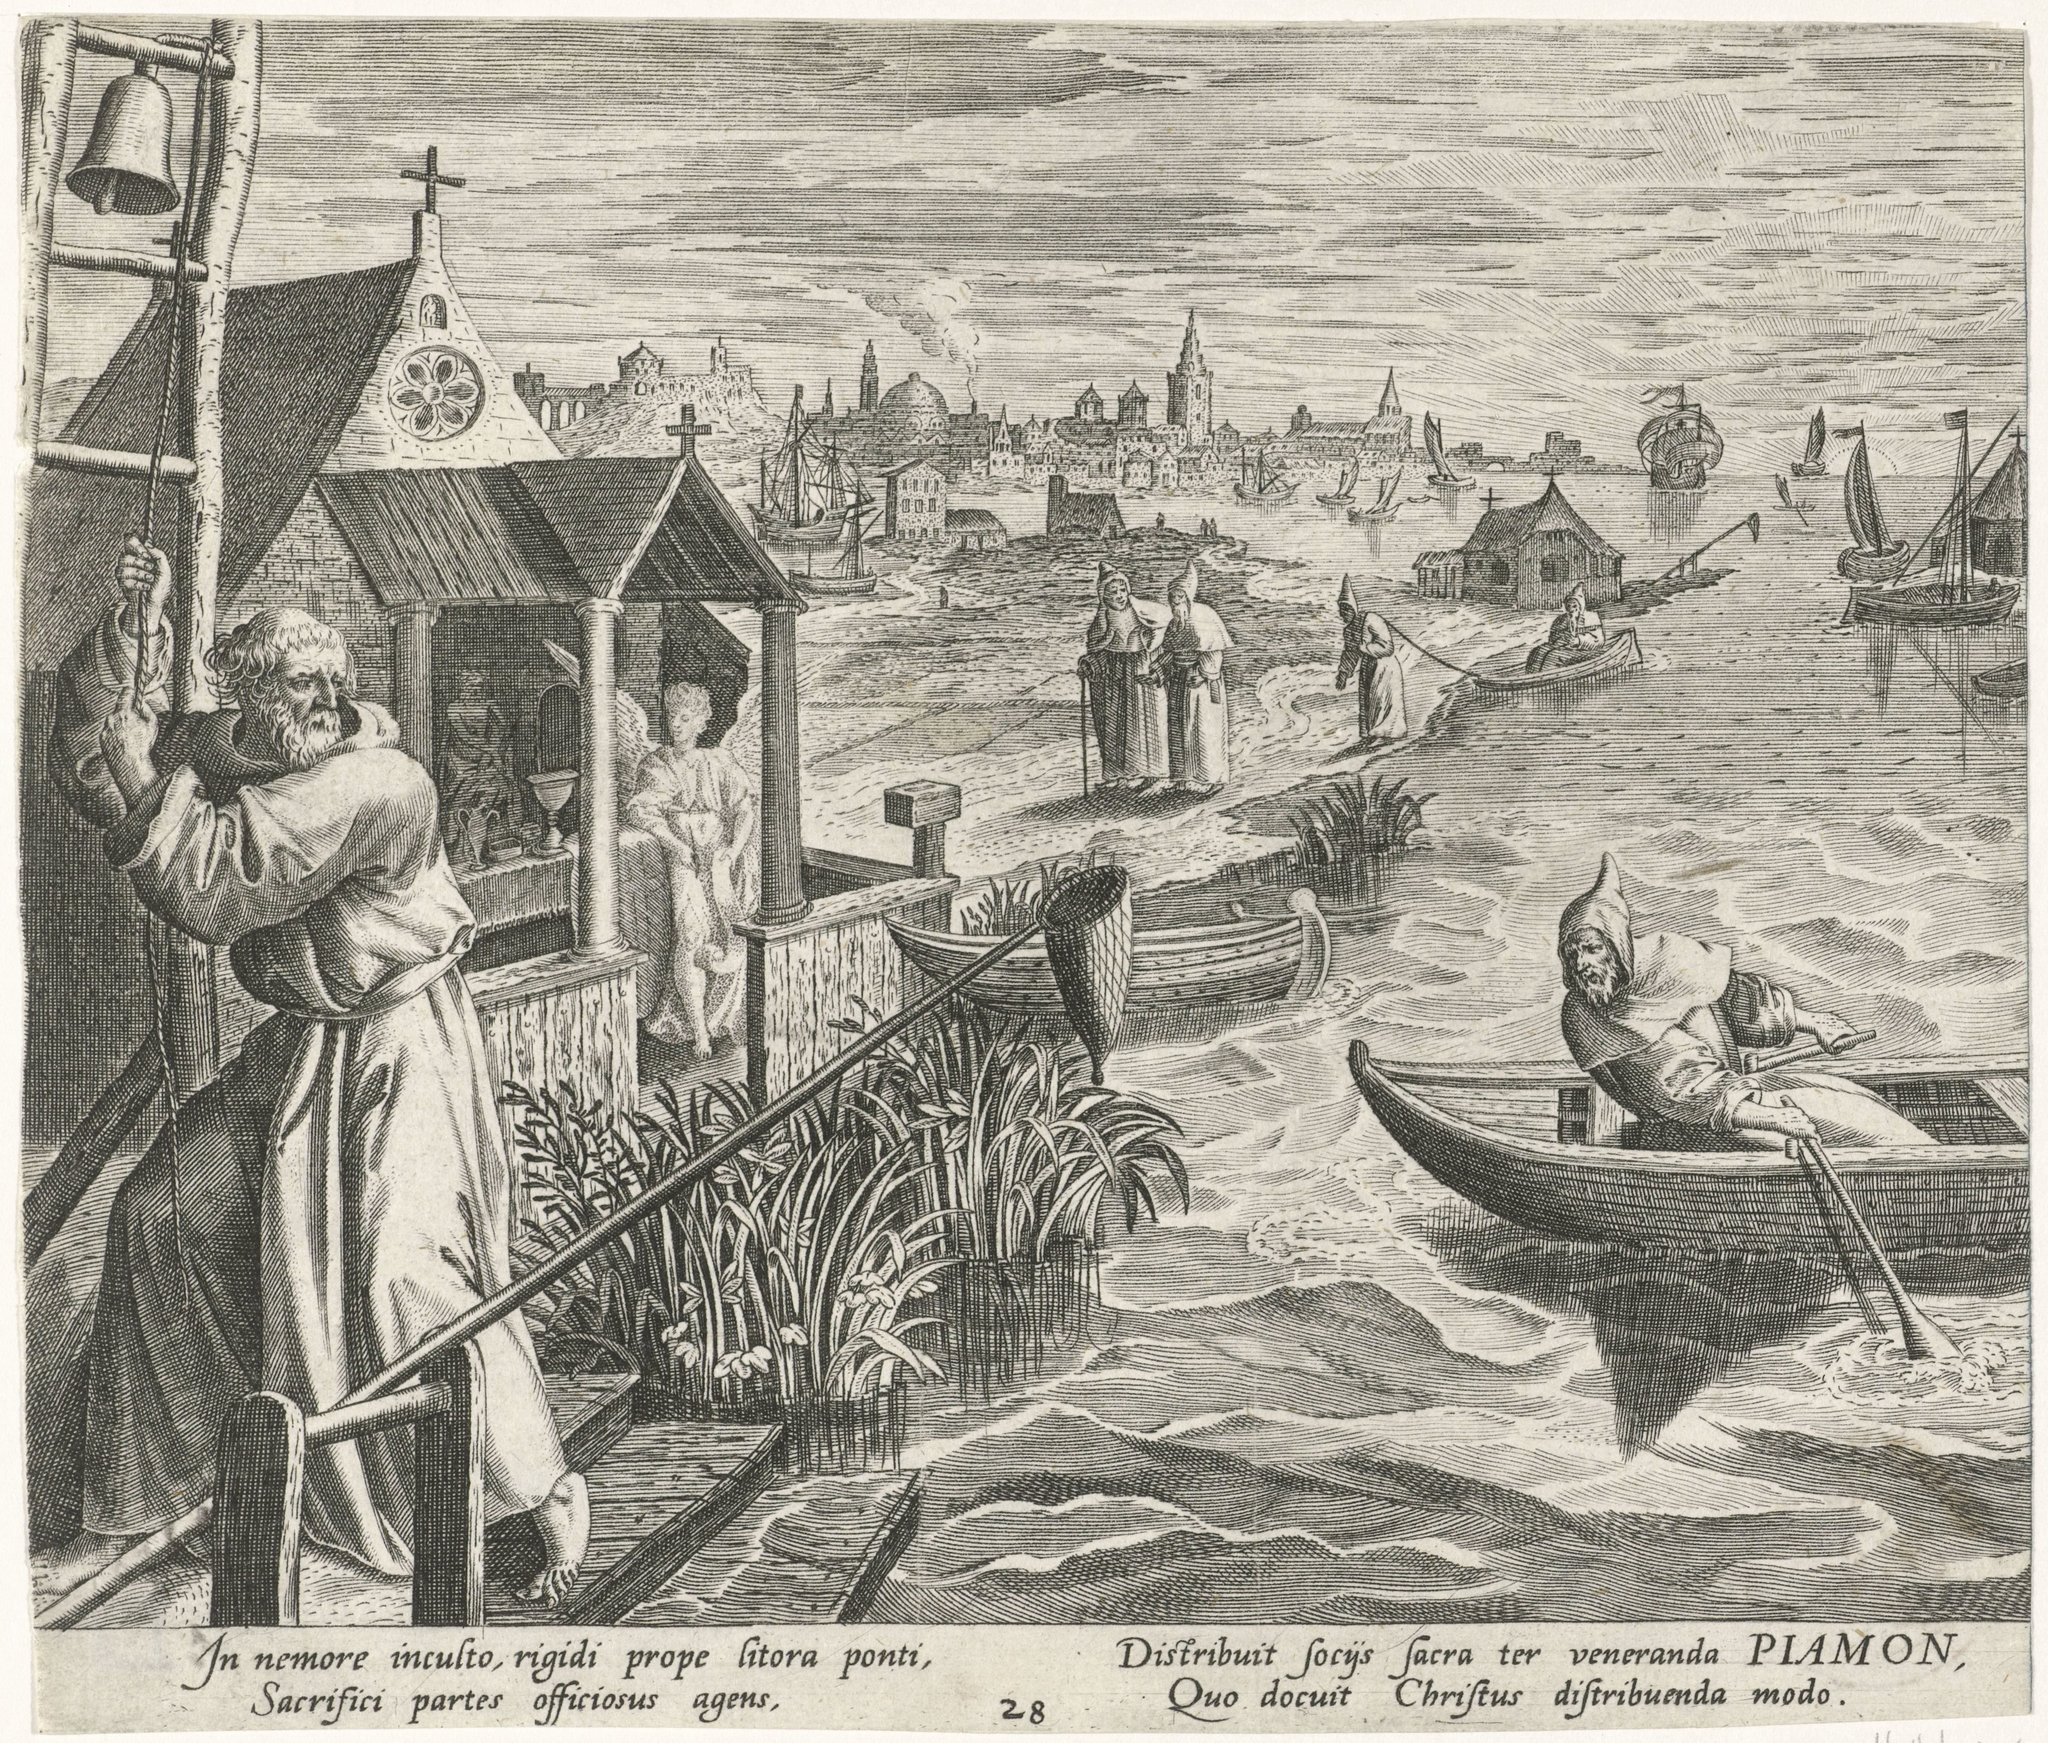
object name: print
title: Mannelijke kluizenaars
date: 1583-1588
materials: paper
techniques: engraving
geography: antwerp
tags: male saints (with name), river, rowing-boat, canoe, etc., anchorite, hermit, angels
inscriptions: collector's mark: Lugt 240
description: De H. Piamon Diocles als kluizenaar. Hij luidt een bel bij een rivier. Achter hem een kerkje met een engel. Op de achtergrond andere kluizenaars.